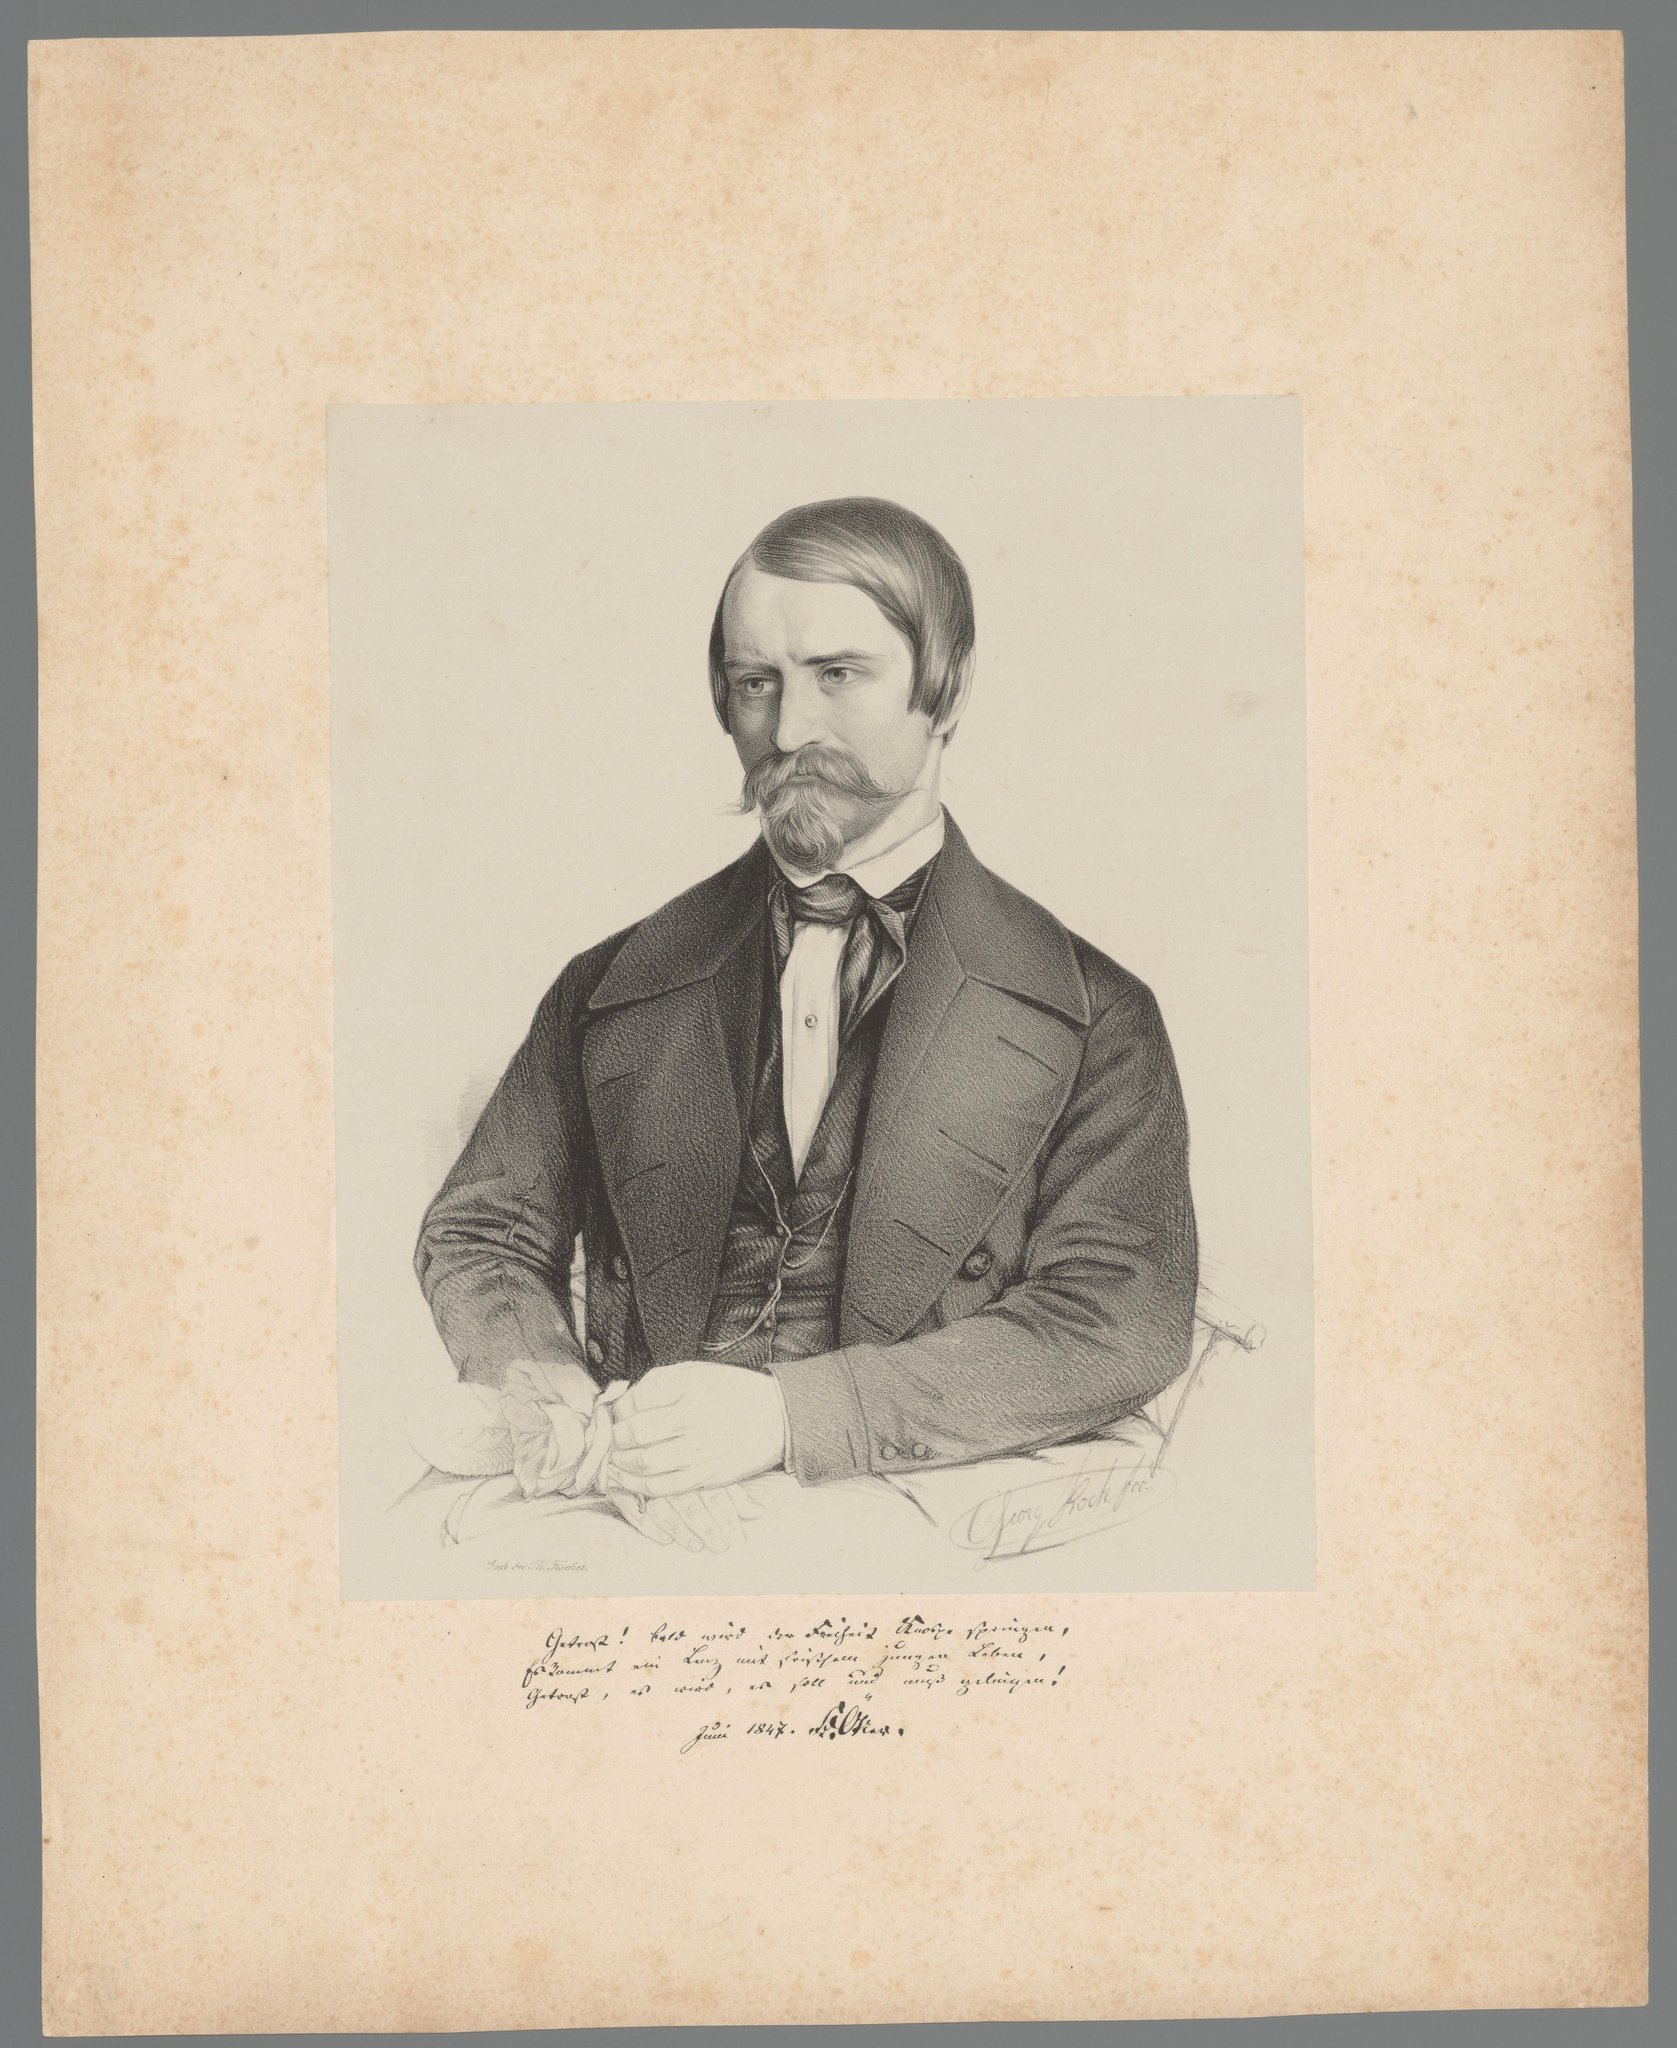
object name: print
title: Portret van een onbekende man met roos in de hand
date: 1847-1899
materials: paper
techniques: lithograph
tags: flowers: rose, historical persons not known by name